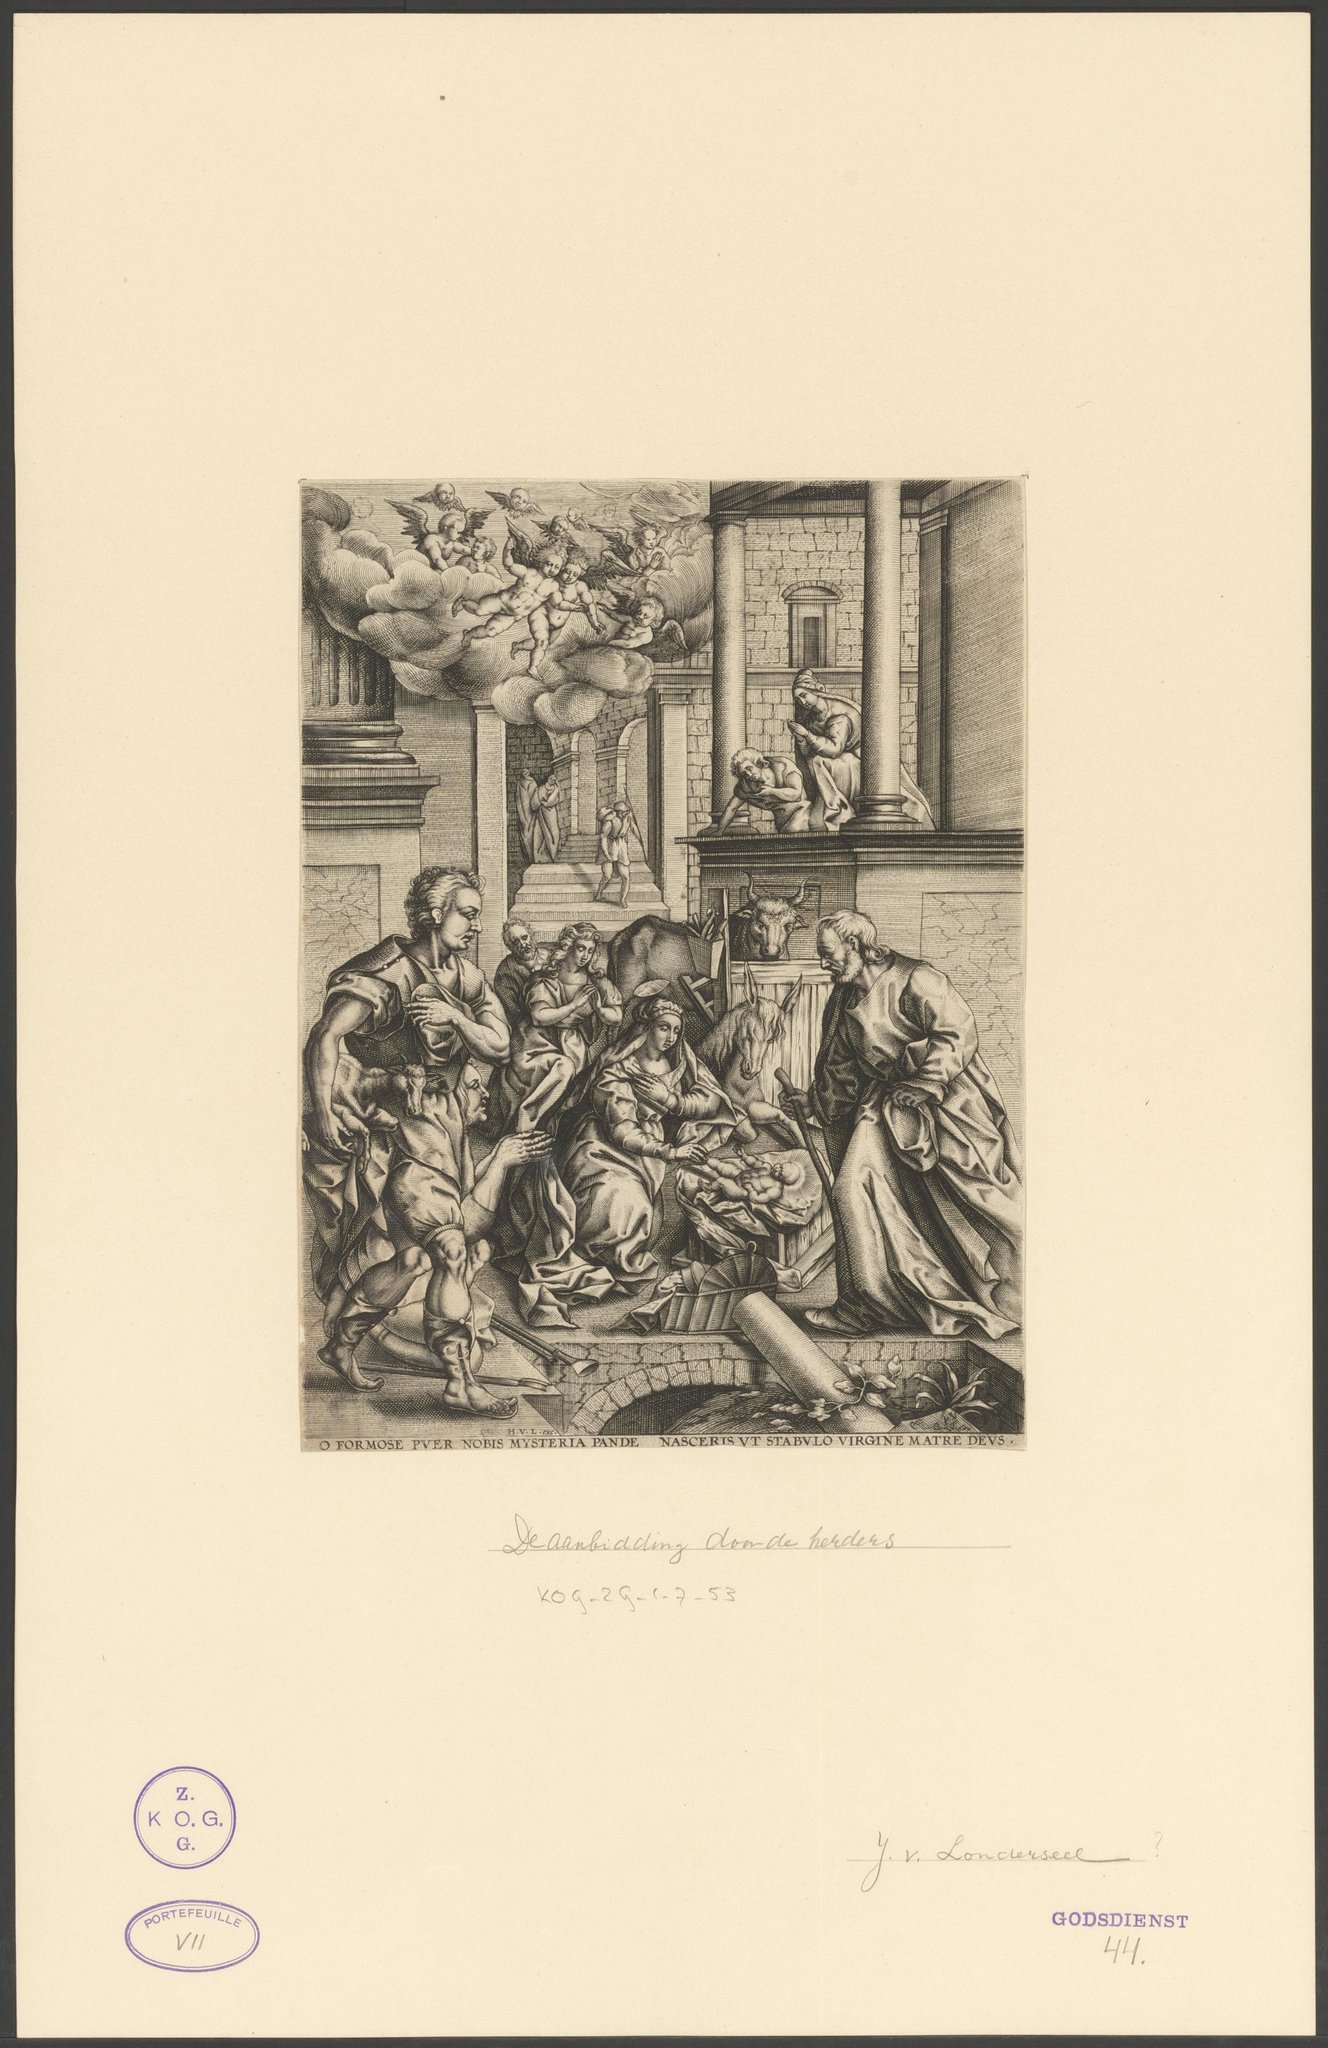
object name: print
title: Aanbidding door de herders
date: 1500-1599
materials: paper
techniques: engraving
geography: antwerp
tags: adoration of the christ-child by the shepherds; mary and joseph present, cupids: 'amores', 'amoretti', 'putti', mary, joseph and the new-born christ (nativity)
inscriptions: signature: ‘H.V.L. exc.’, stamp, collector's mark: Lugt 1641, signature: ‘IAD W F’, stamp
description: Onderwerpsrubrieken binnen de Atlas Zeden en Gewoonten: Godsdienst, Roomsch-Katholieken, Processies, Herinneringen.